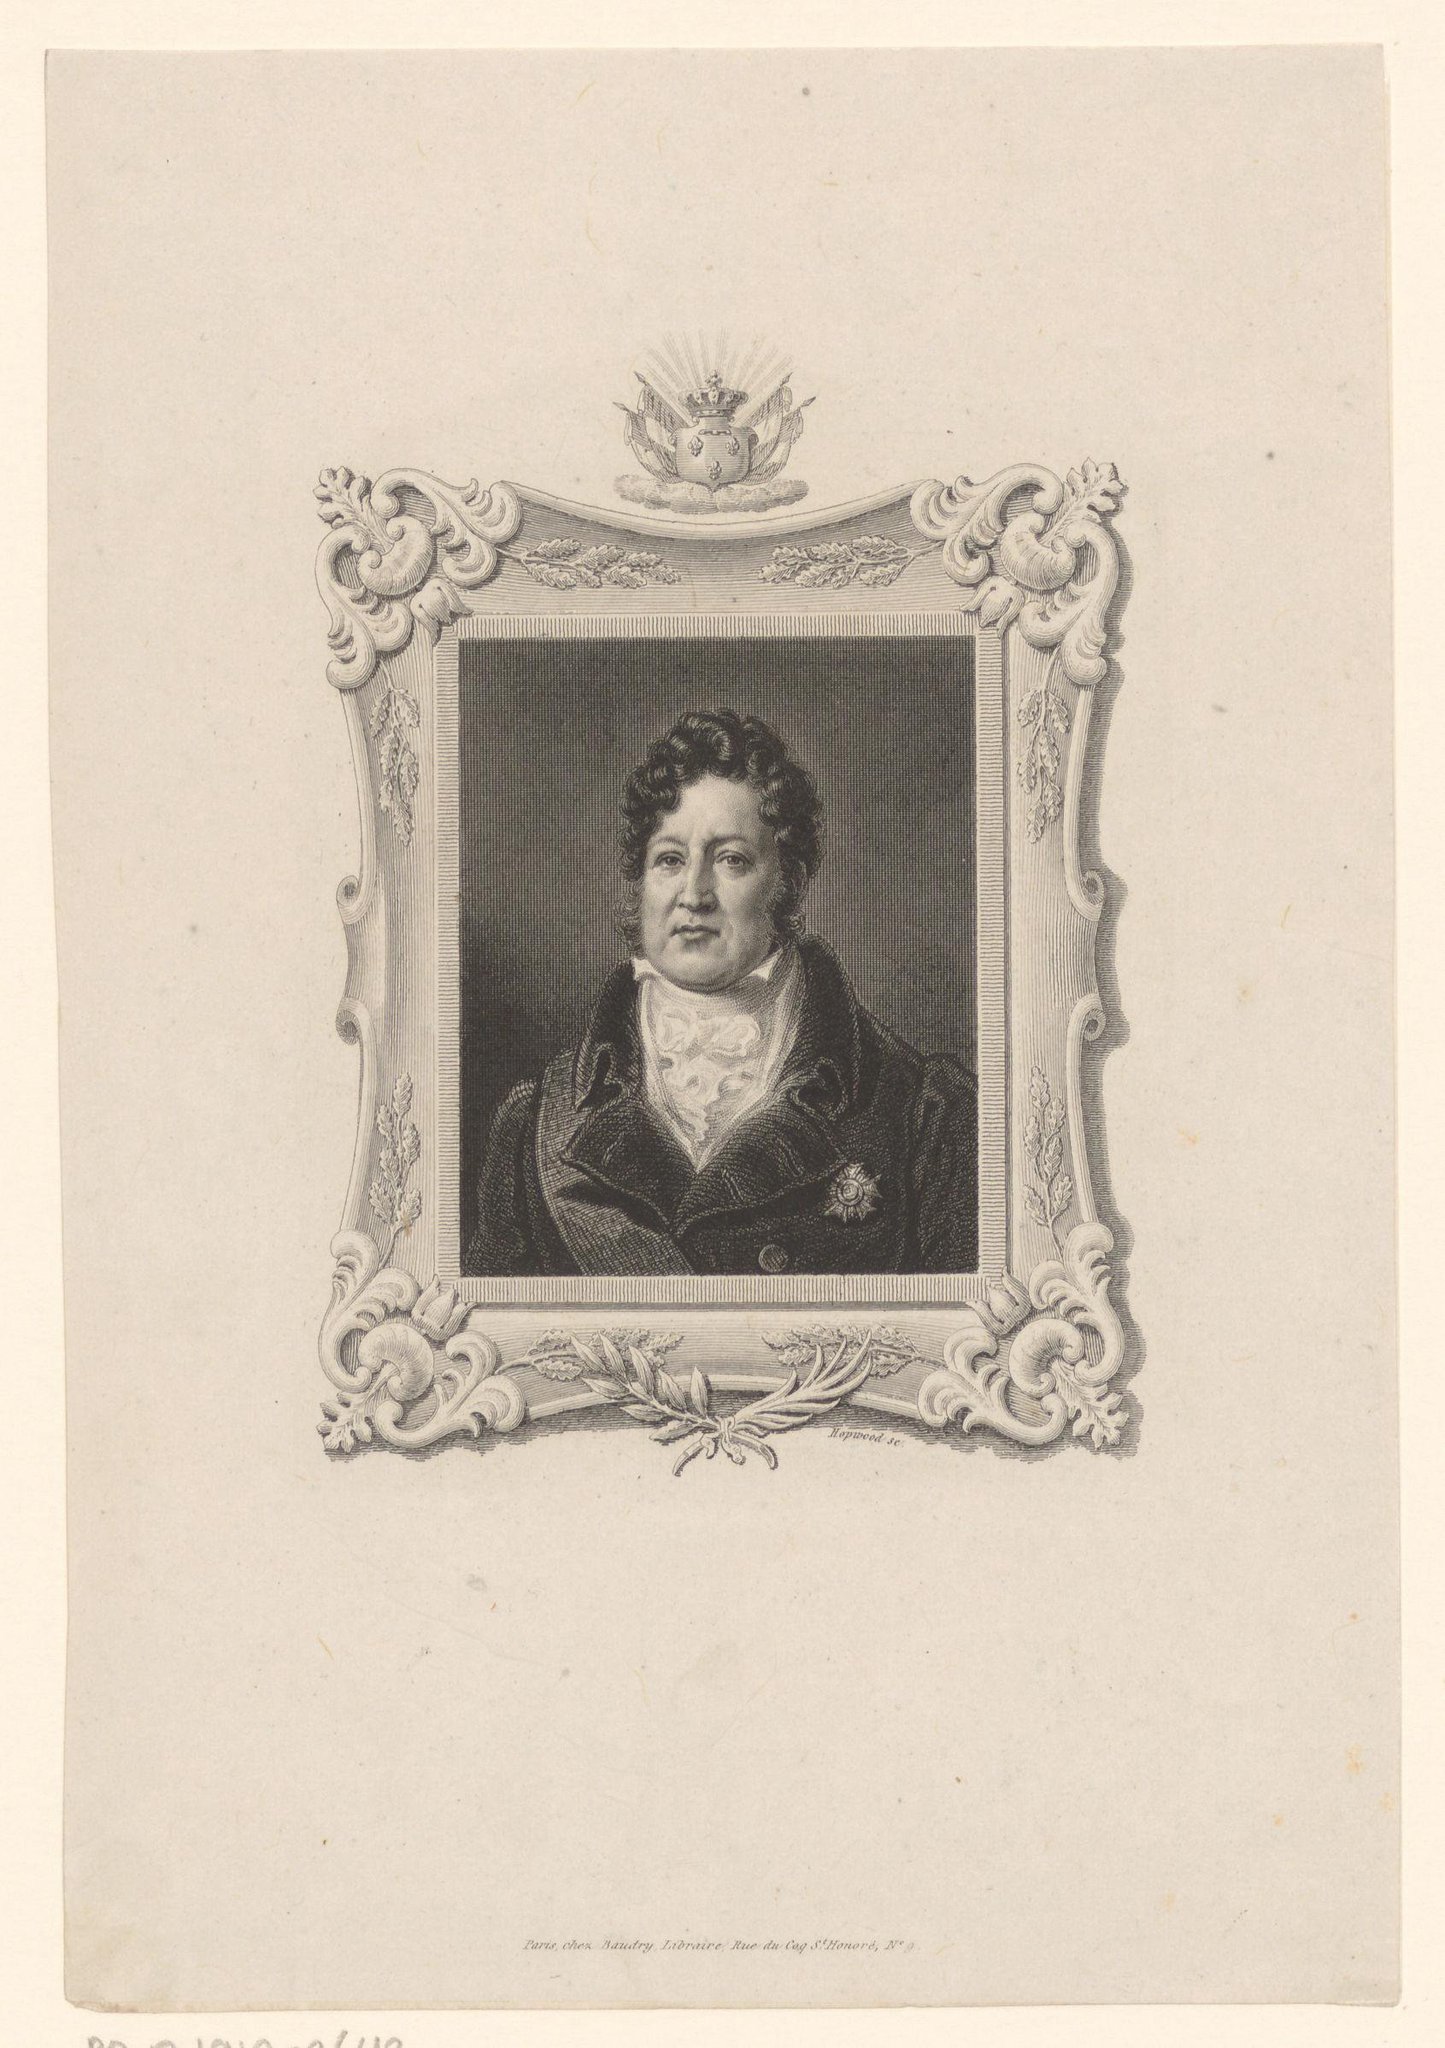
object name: print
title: Portret van Lodewijk Filips I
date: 1830-1848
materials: paper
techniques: etching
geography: paris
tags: paris, lodewijk filips i (koning van frankrijk), historical persons, king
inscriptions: collector's mark: Lugt 2228